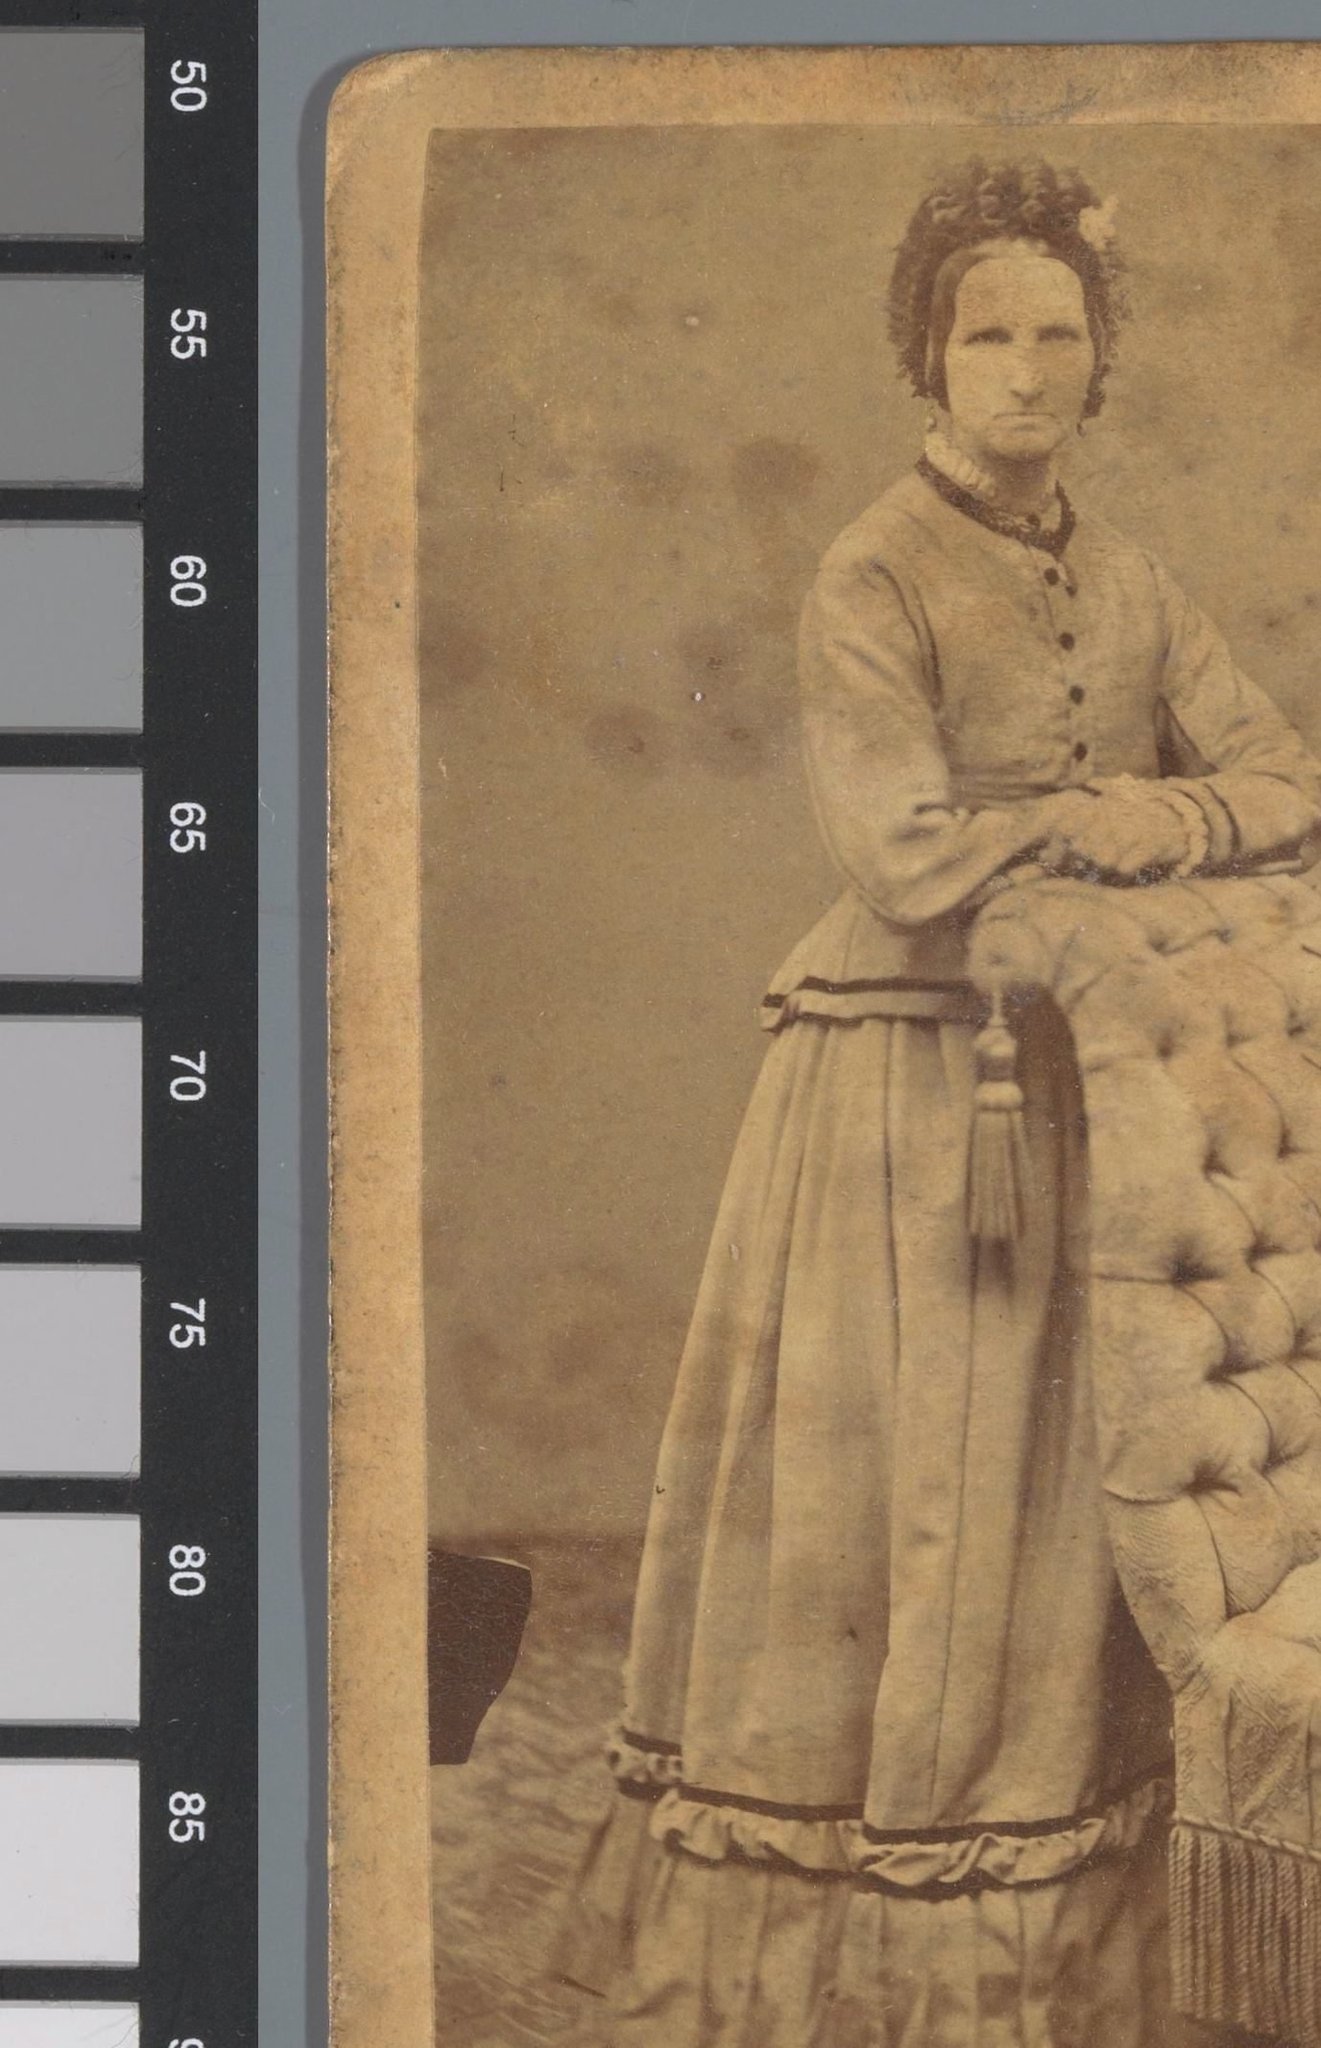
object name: photograph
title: Portret van een onbekende vrouw bij een stoel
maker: hermanus jodocus weesing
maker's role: fotograaf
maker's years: 1844-1910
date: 1868-1900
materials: cardboard, paper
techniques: albumen print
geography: amsterdam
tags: adult woman, anonymous historical person portrayed, amsterdam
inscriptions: inscription: ‘No.../ H.J. Weesing/ Photograaf/ Binnen Brouwerstraat 5./ Amsterdam.’, inscription: ‘H.J. Weesing Amsterdam.’